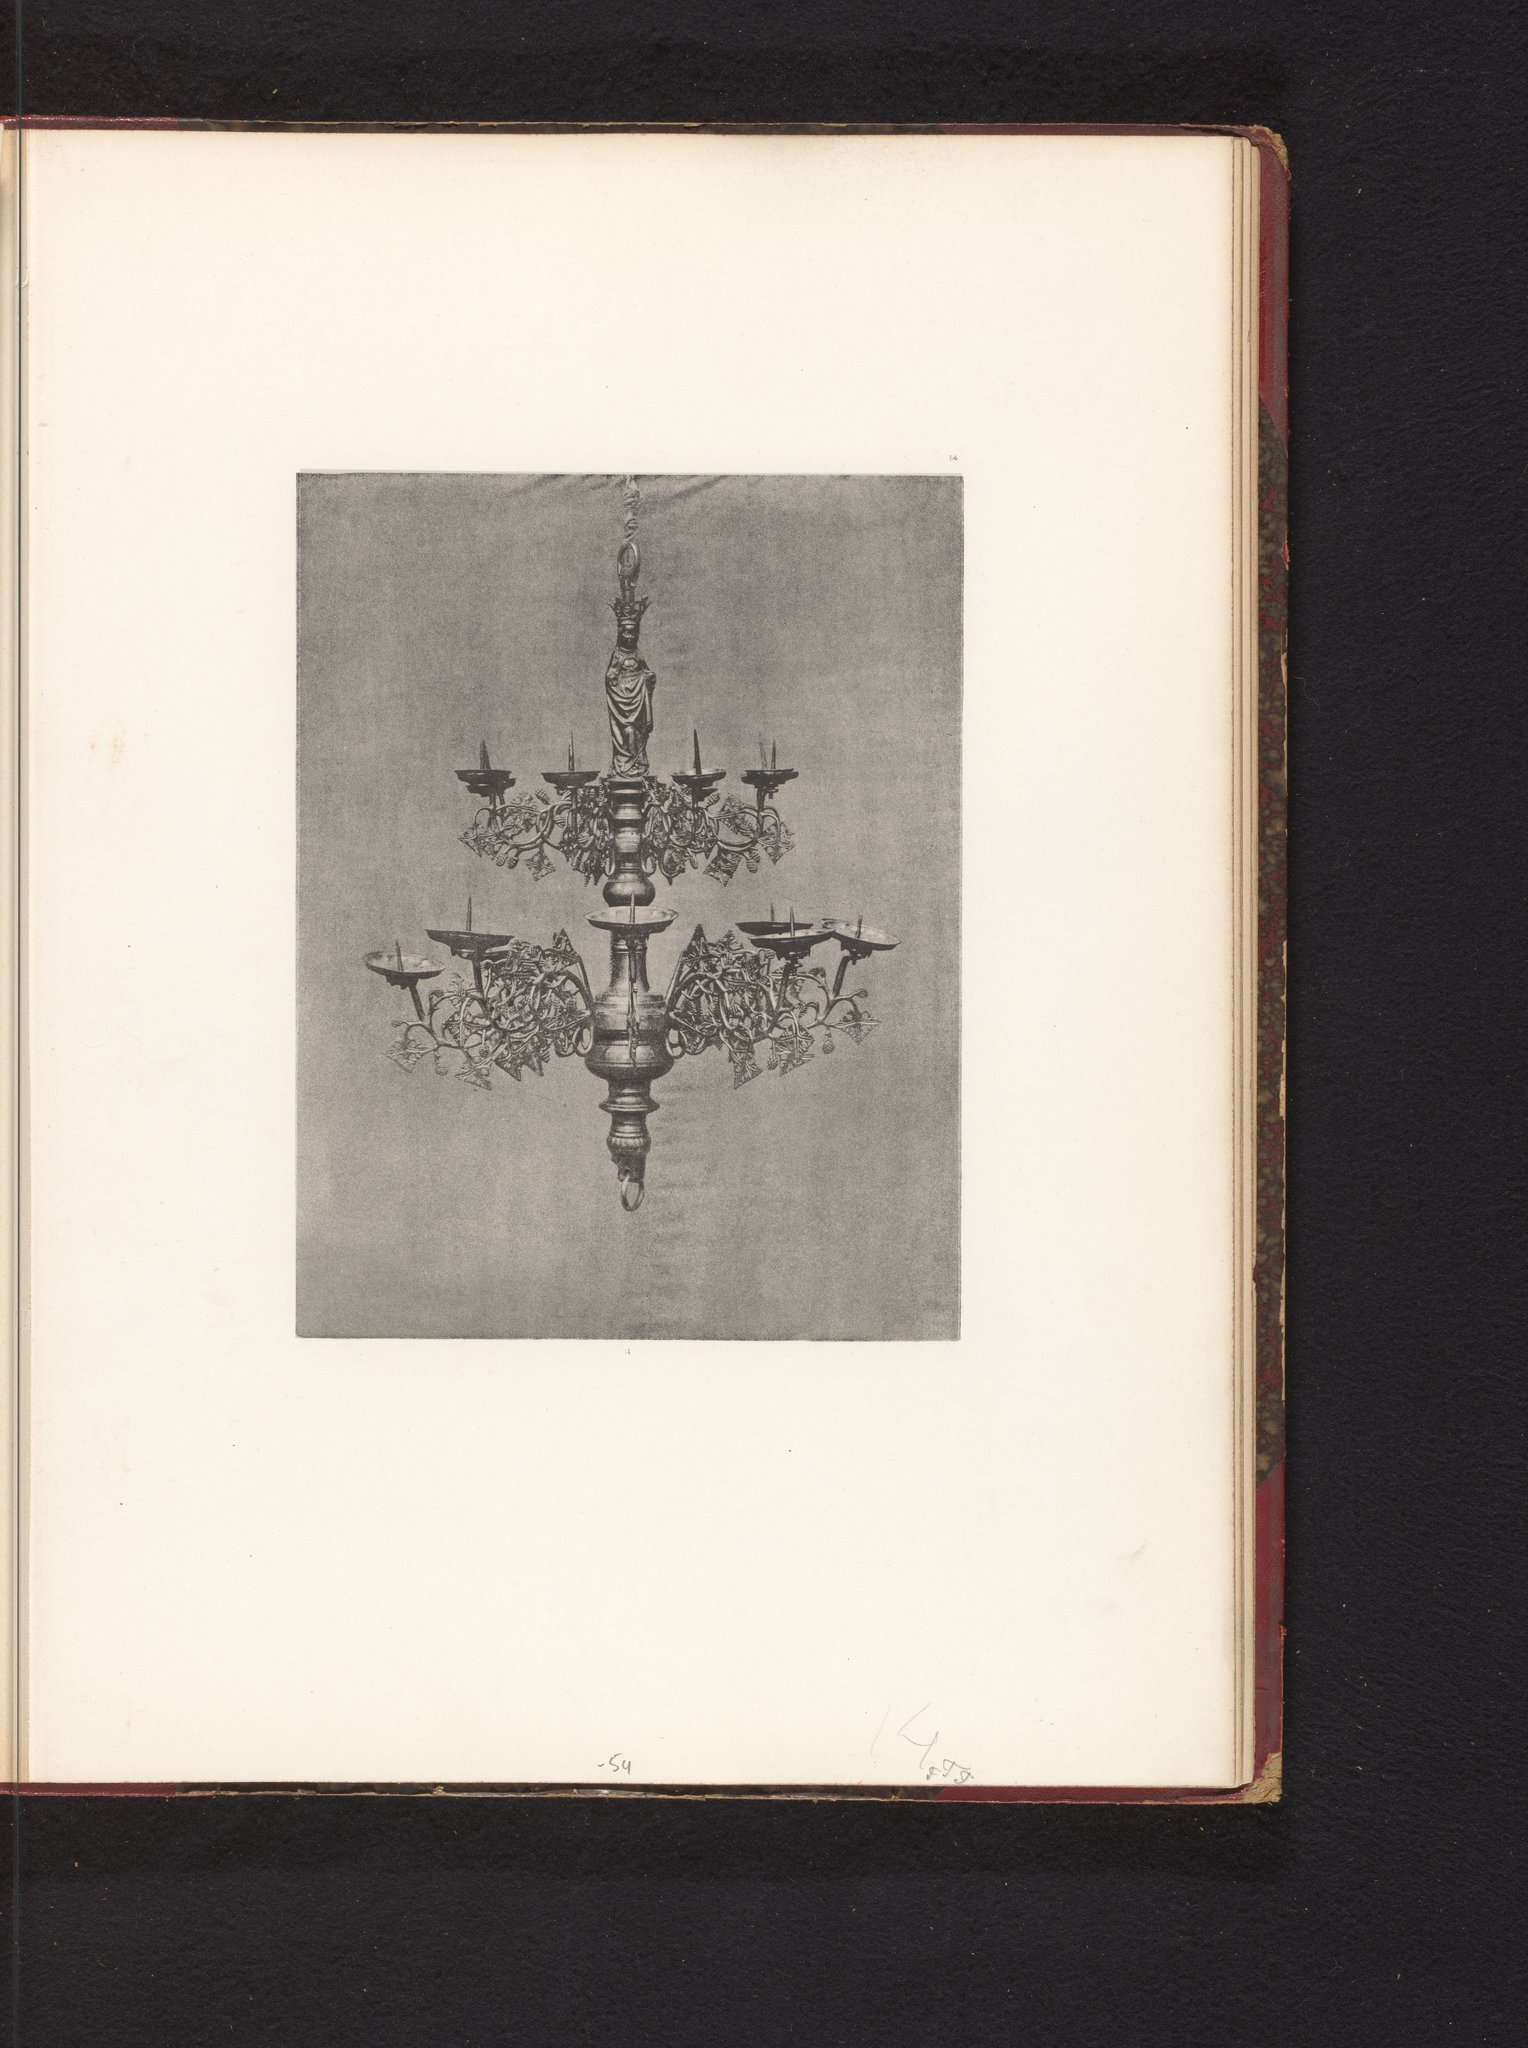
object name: page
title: Metalen kroonluchter uit een kerk in Mechelen, opgesteld op een tentoonstelling over religieuze objecten uit de middeleeuwen en renaissance in 1864 in Mechelen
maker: joseph maes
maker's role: fotograaf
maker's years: 1838-1908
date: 1864-1866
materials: paper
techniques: photolithography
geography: antwerp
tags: chandelier, candelabrum, mechelen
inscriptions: number: ‘14’, number: ‘14/ [...]’, number: ‘-54’